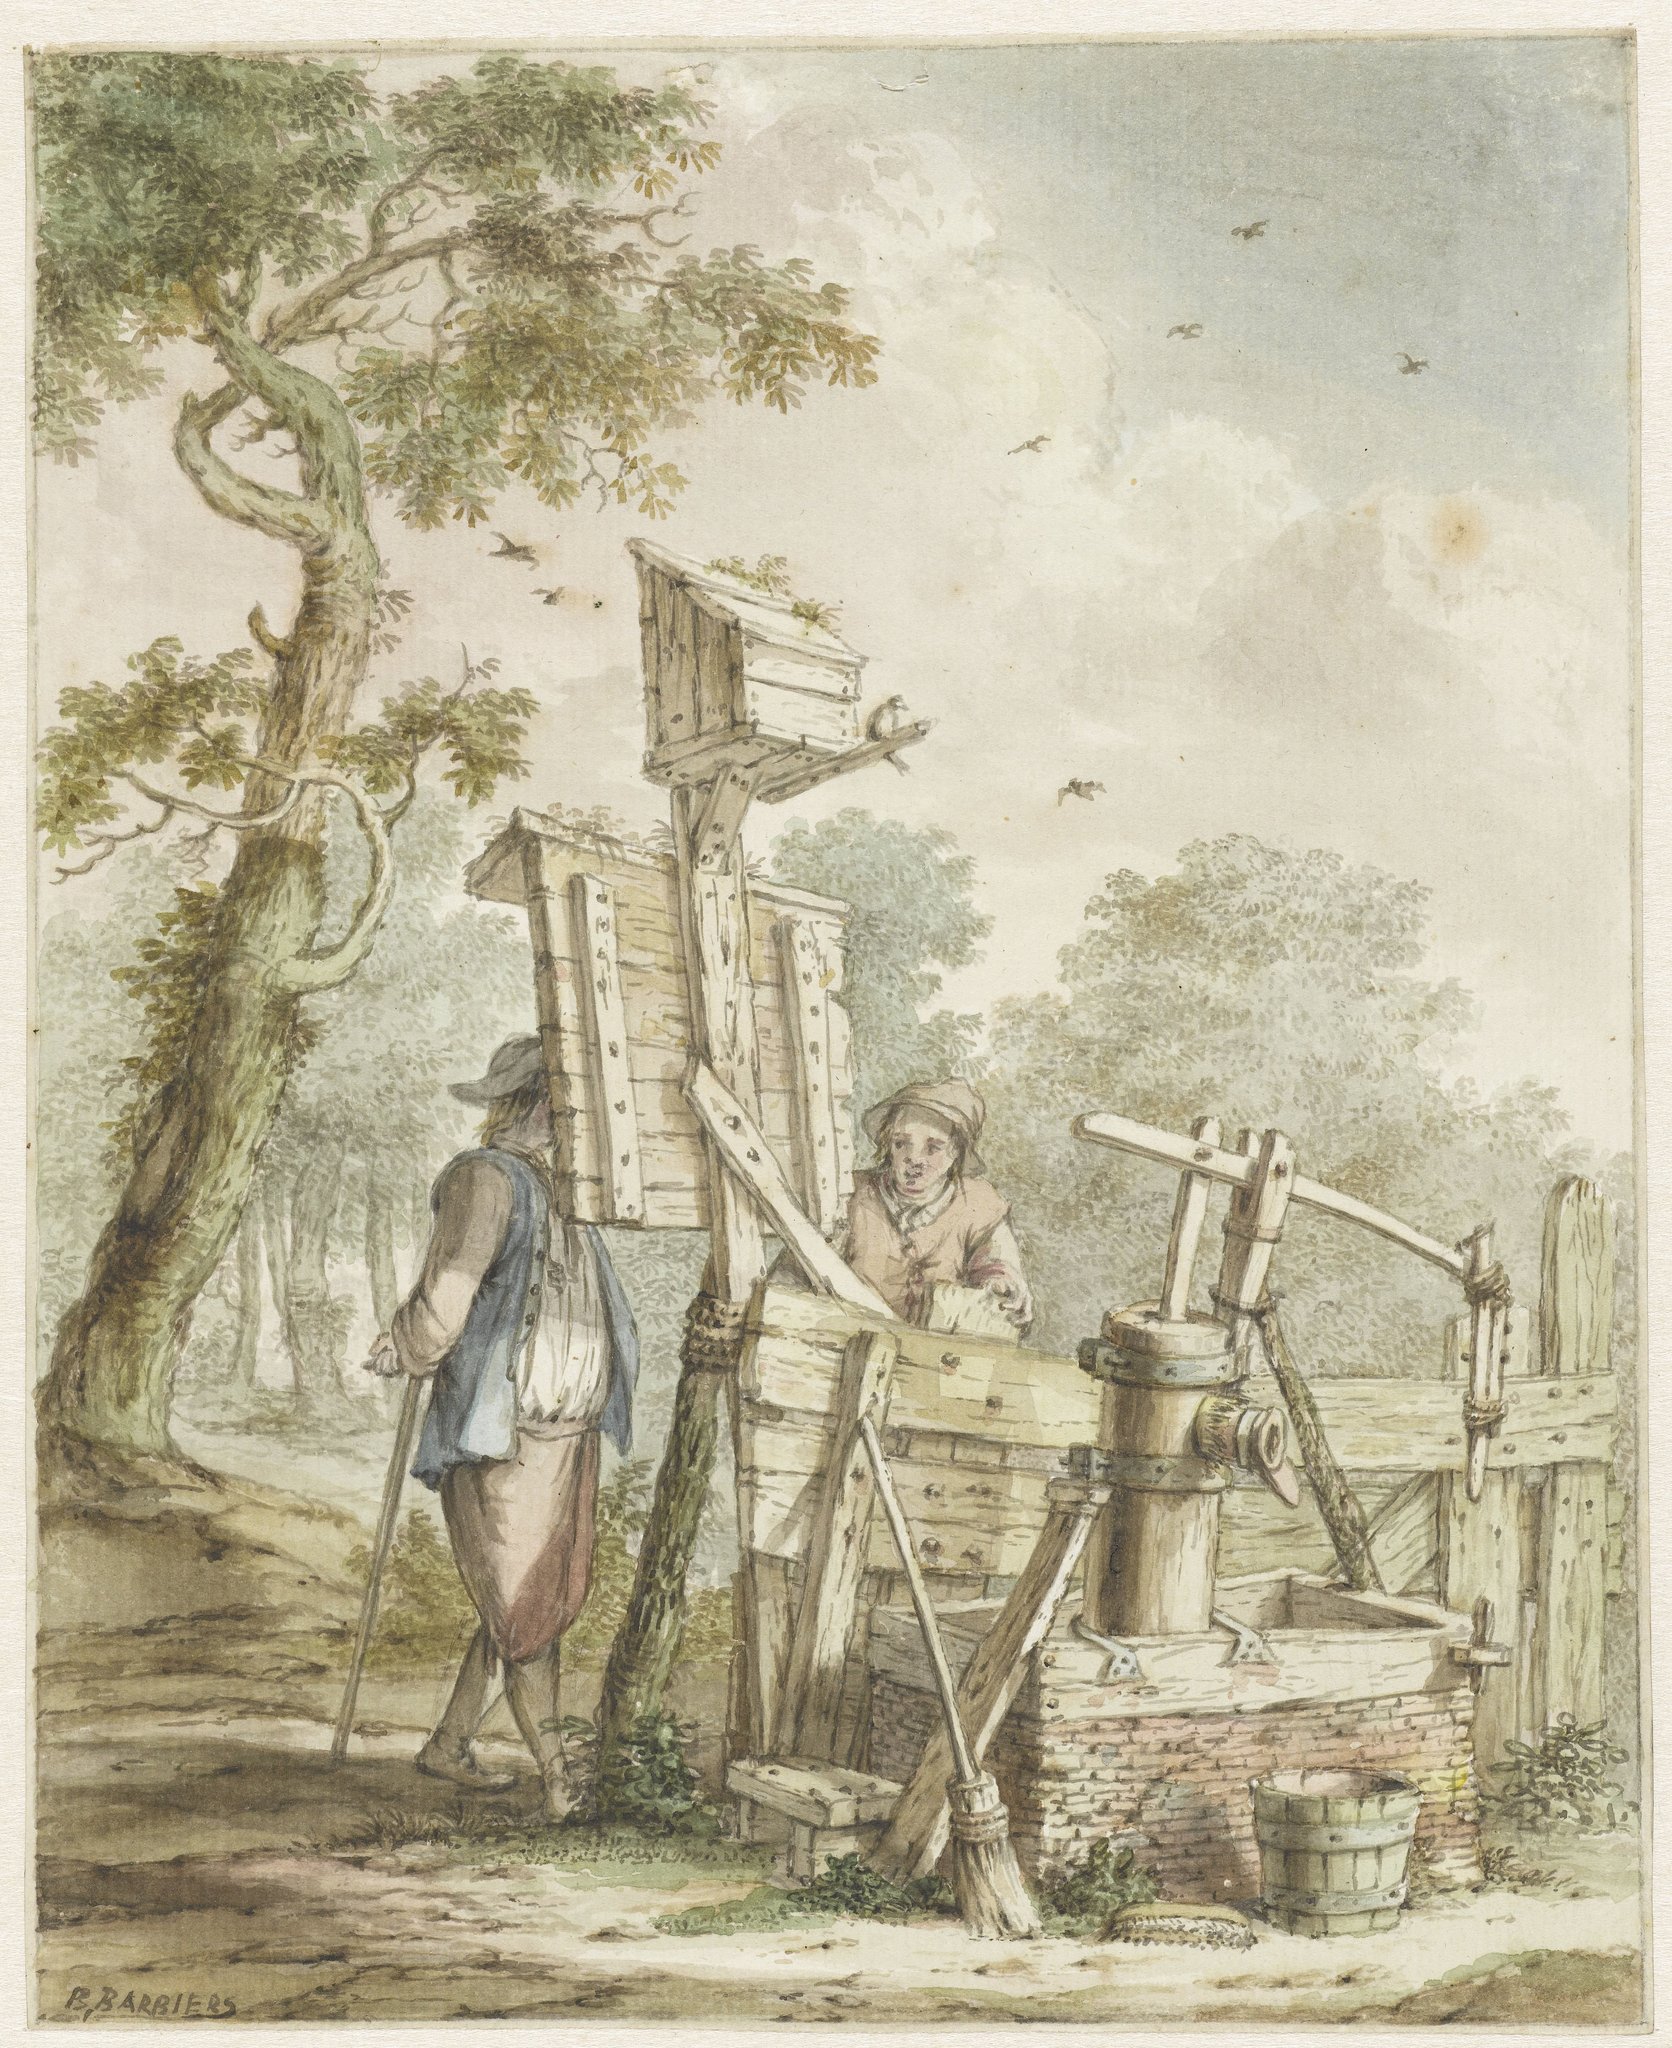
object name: watercolor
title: Landschap met twee mannen bij een aanplakbord bij een waterpomp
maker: bartholomeus barbiers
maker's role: draughtsman, painter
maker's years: 1740-1808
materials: graphite, ink, paper, watercolor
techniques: brush, pen